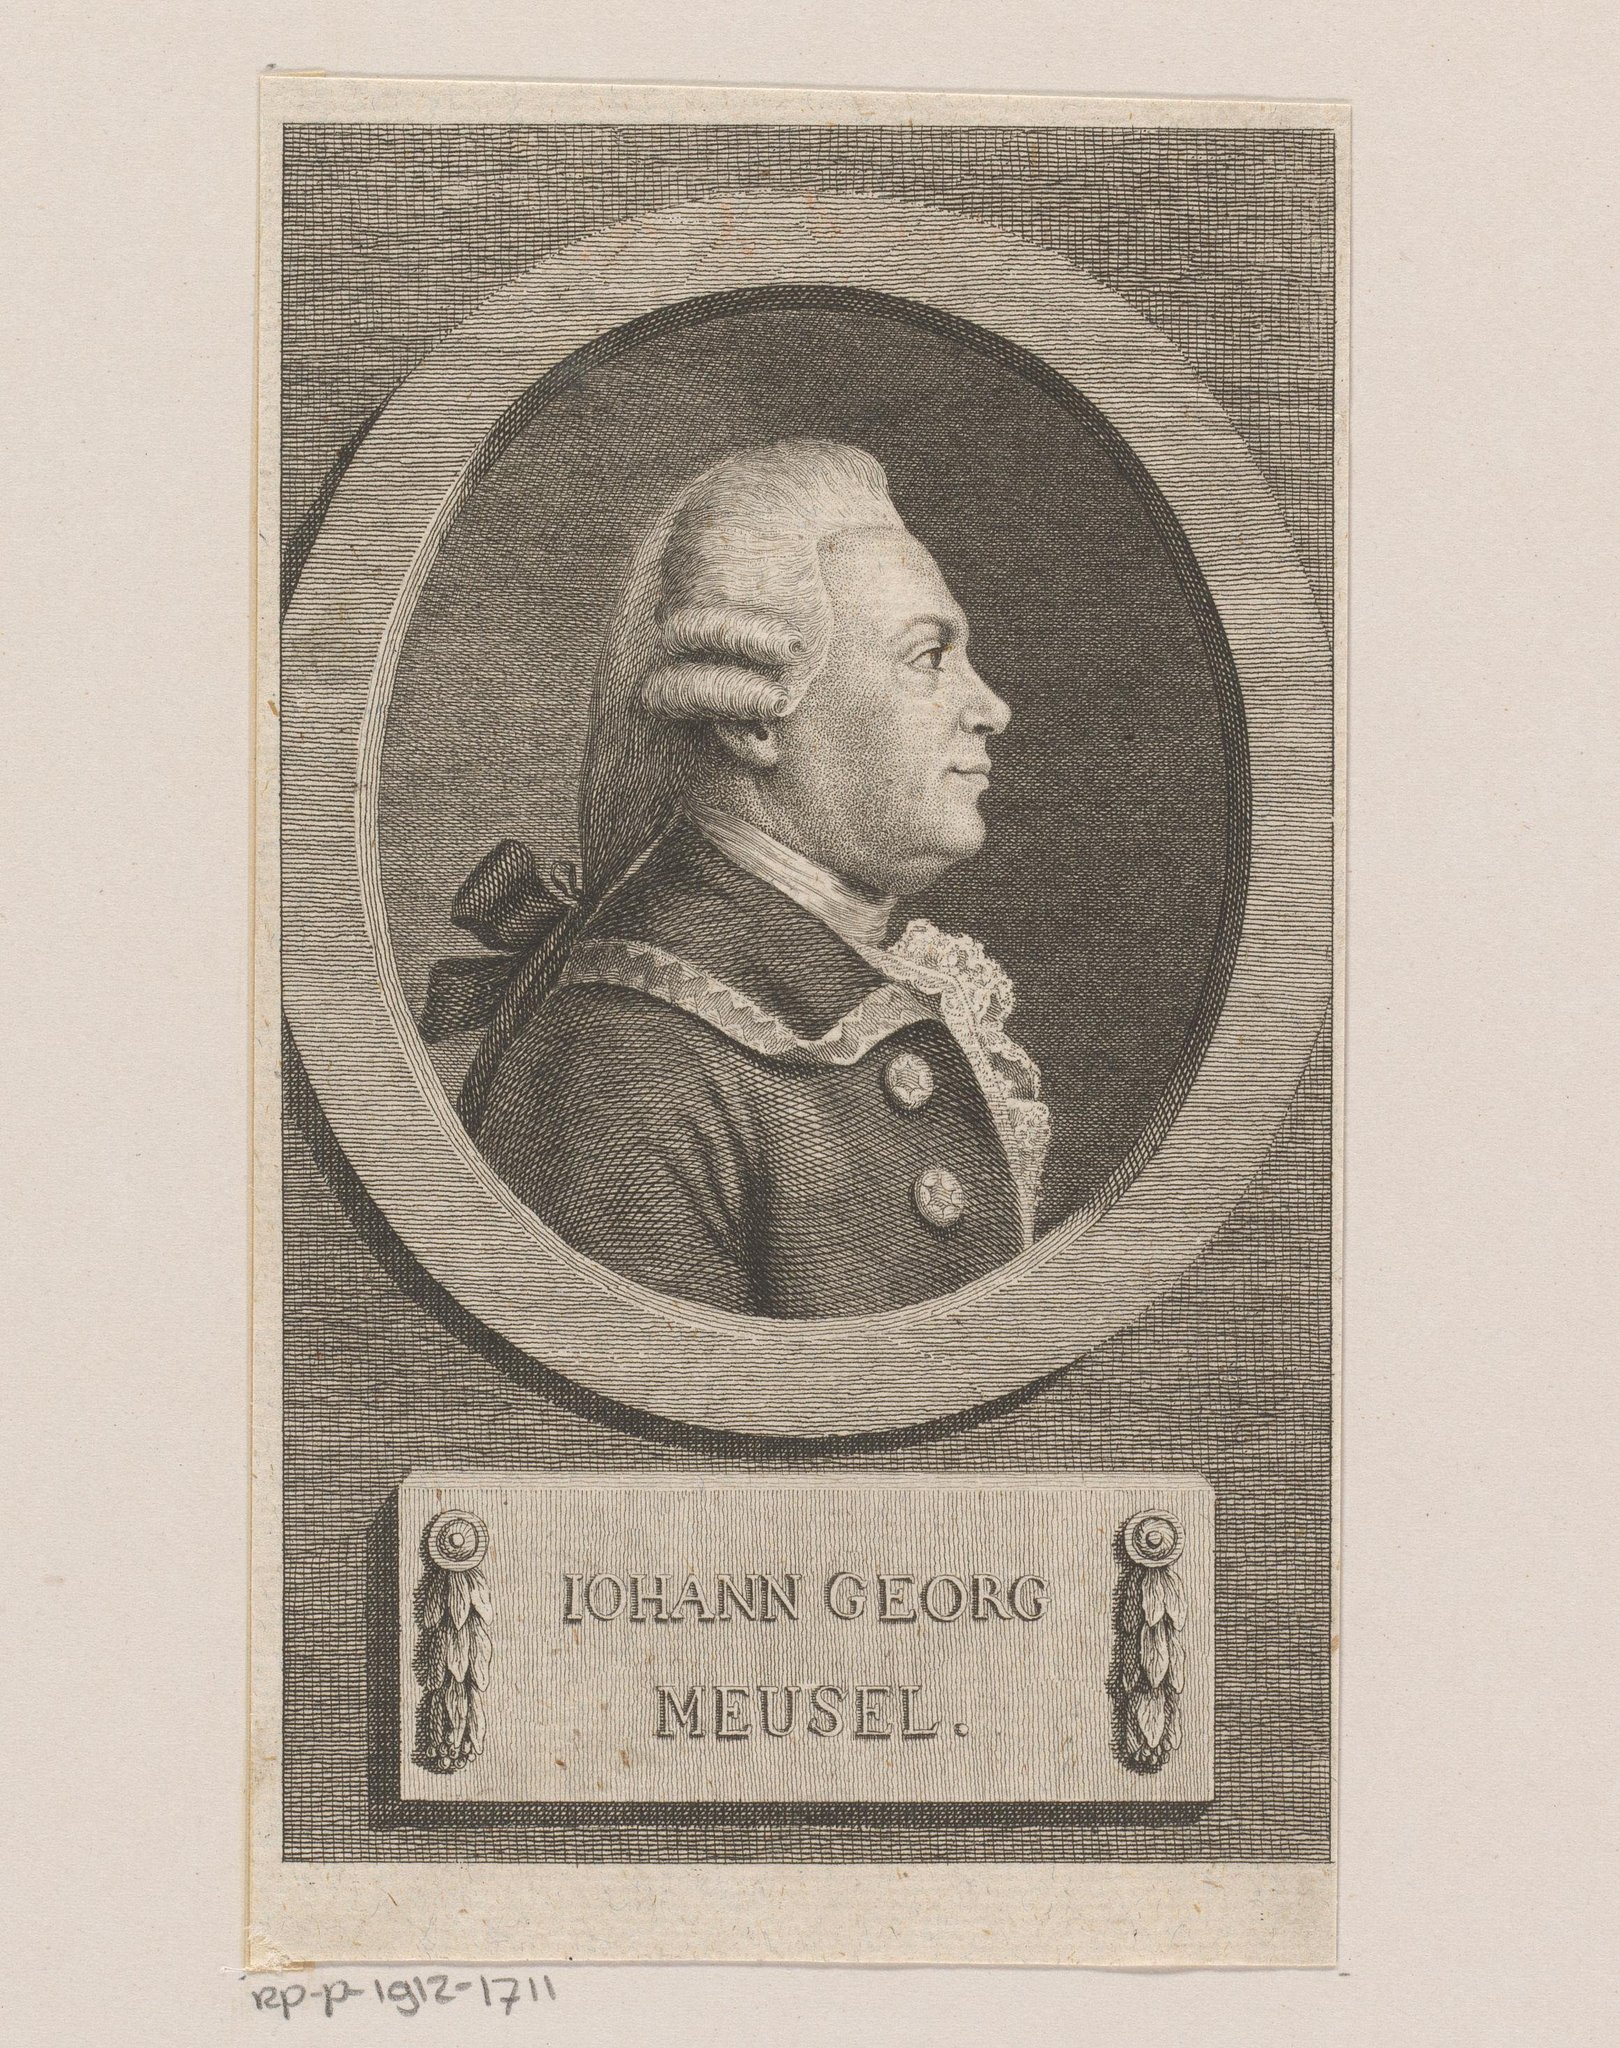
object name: book illustration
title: Portret van Johann Georg Meusel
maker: eberhard siegfried henne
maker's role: print maker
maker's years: 1759-1828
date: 1790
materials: paper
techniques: engraving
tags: historical persons, professor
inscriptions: collector's mark: Lugt 2228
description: Prent waarschijnlijk uit: Allgemeine deutsche Bibliothek. Berlijn en Stettin: Friedrich Nicolai, 1790, dl. 95.